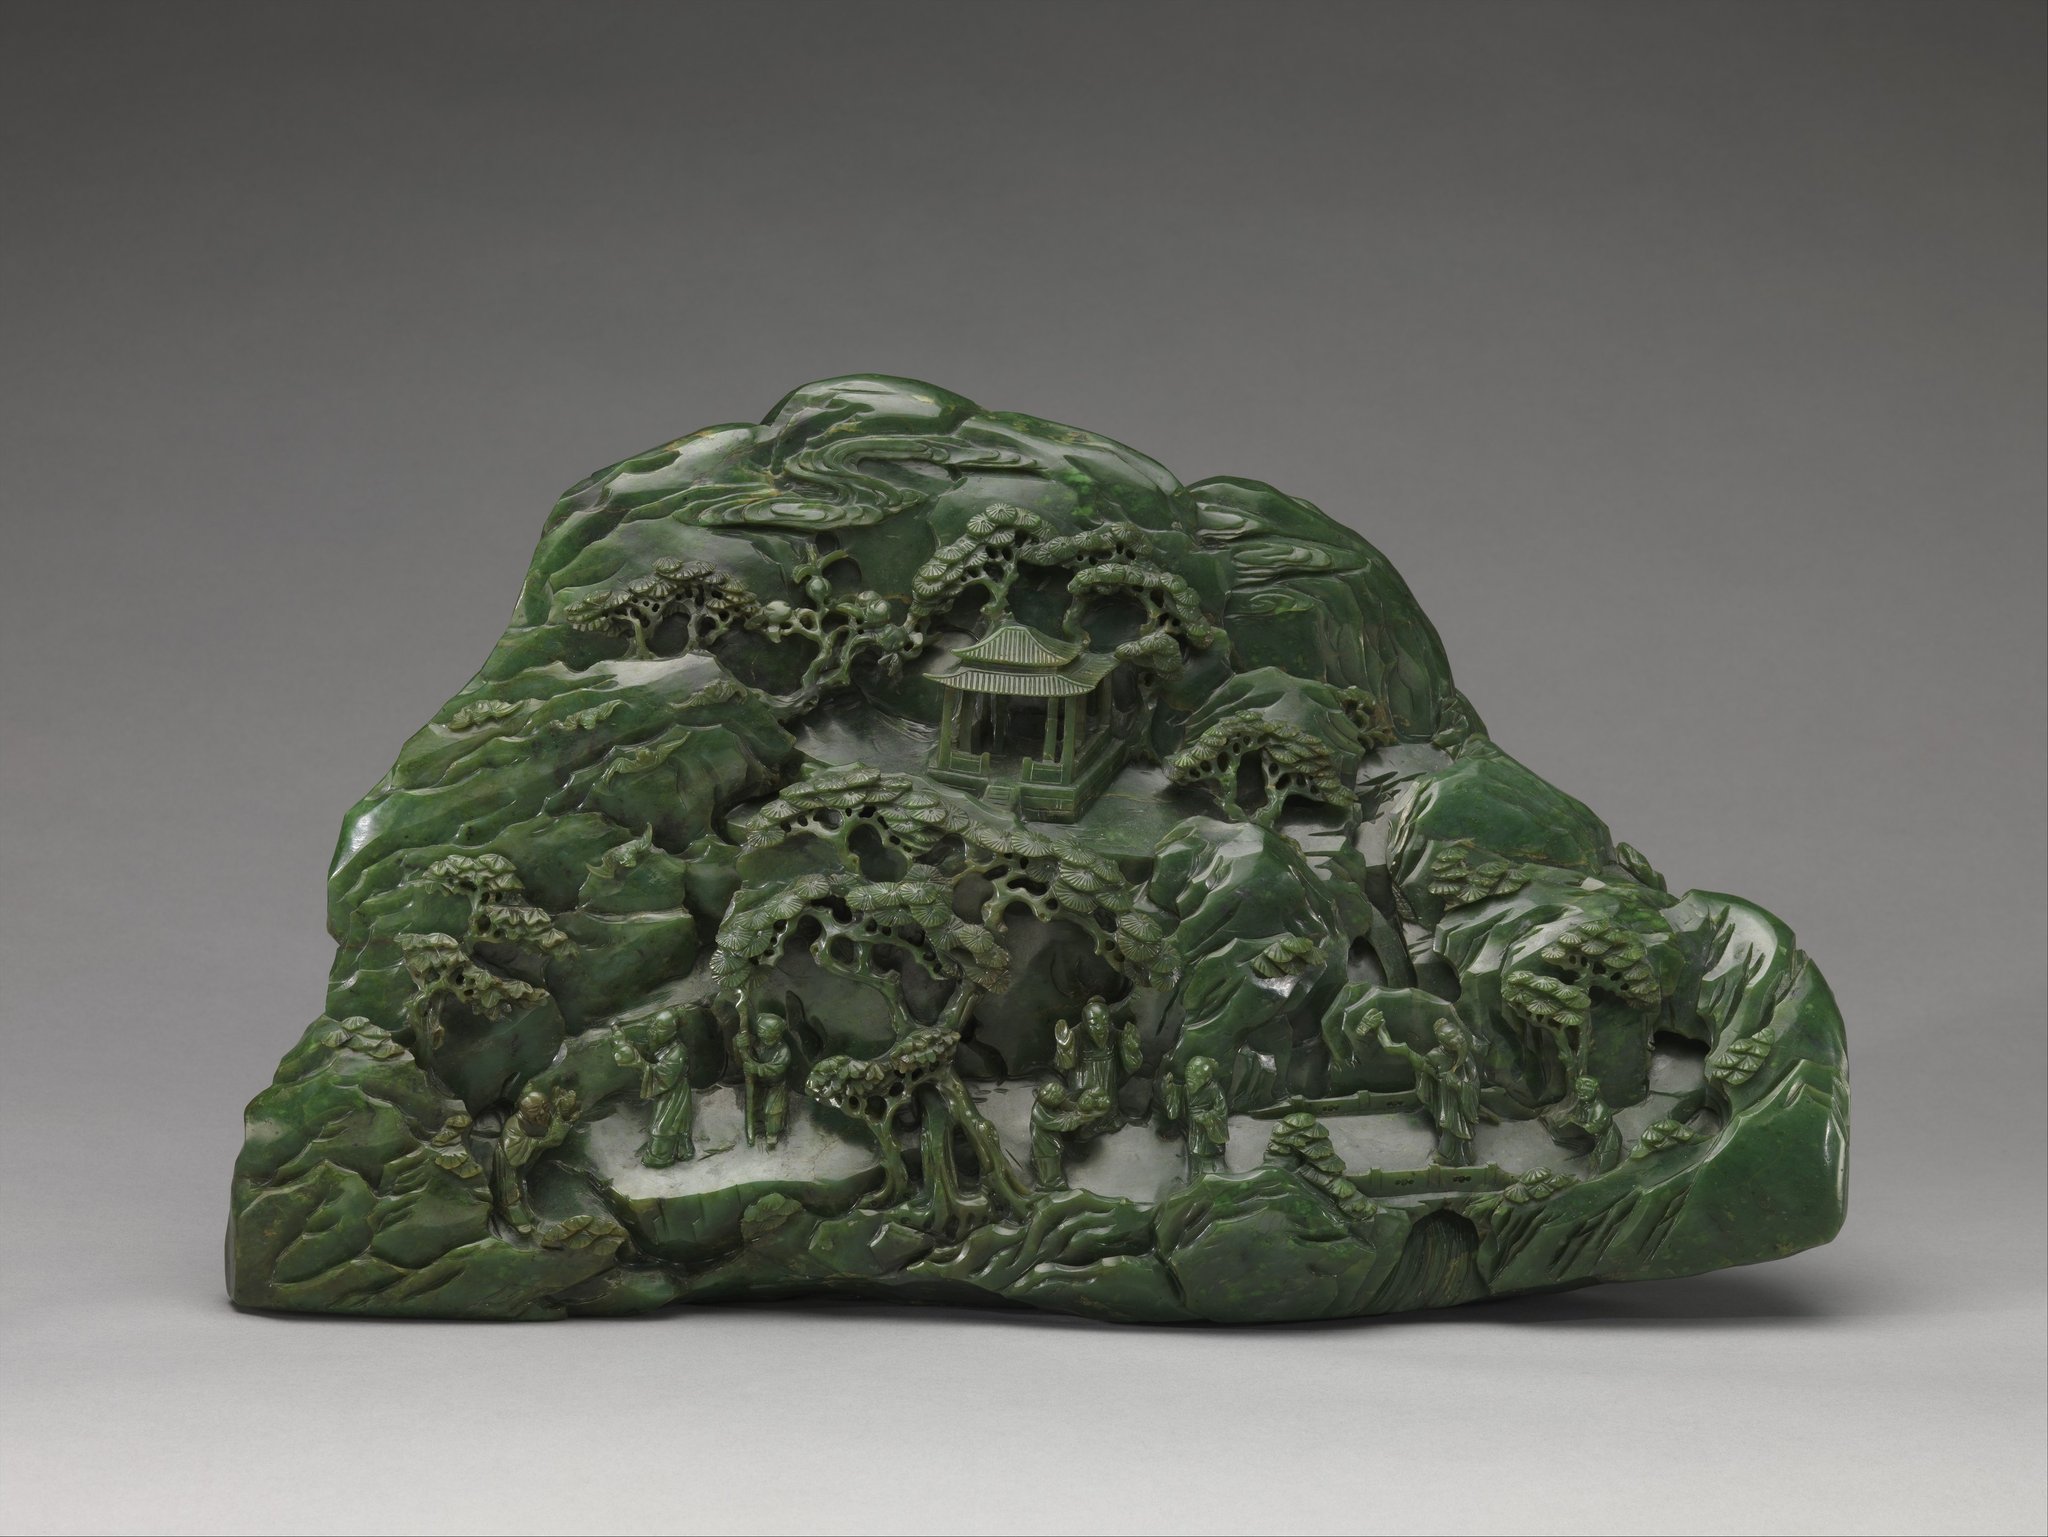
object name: boulder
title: Boulder with Daoist paradise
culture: chinese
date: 1701-1800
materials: jade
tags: men,mountains,landscapes,trees,daoism